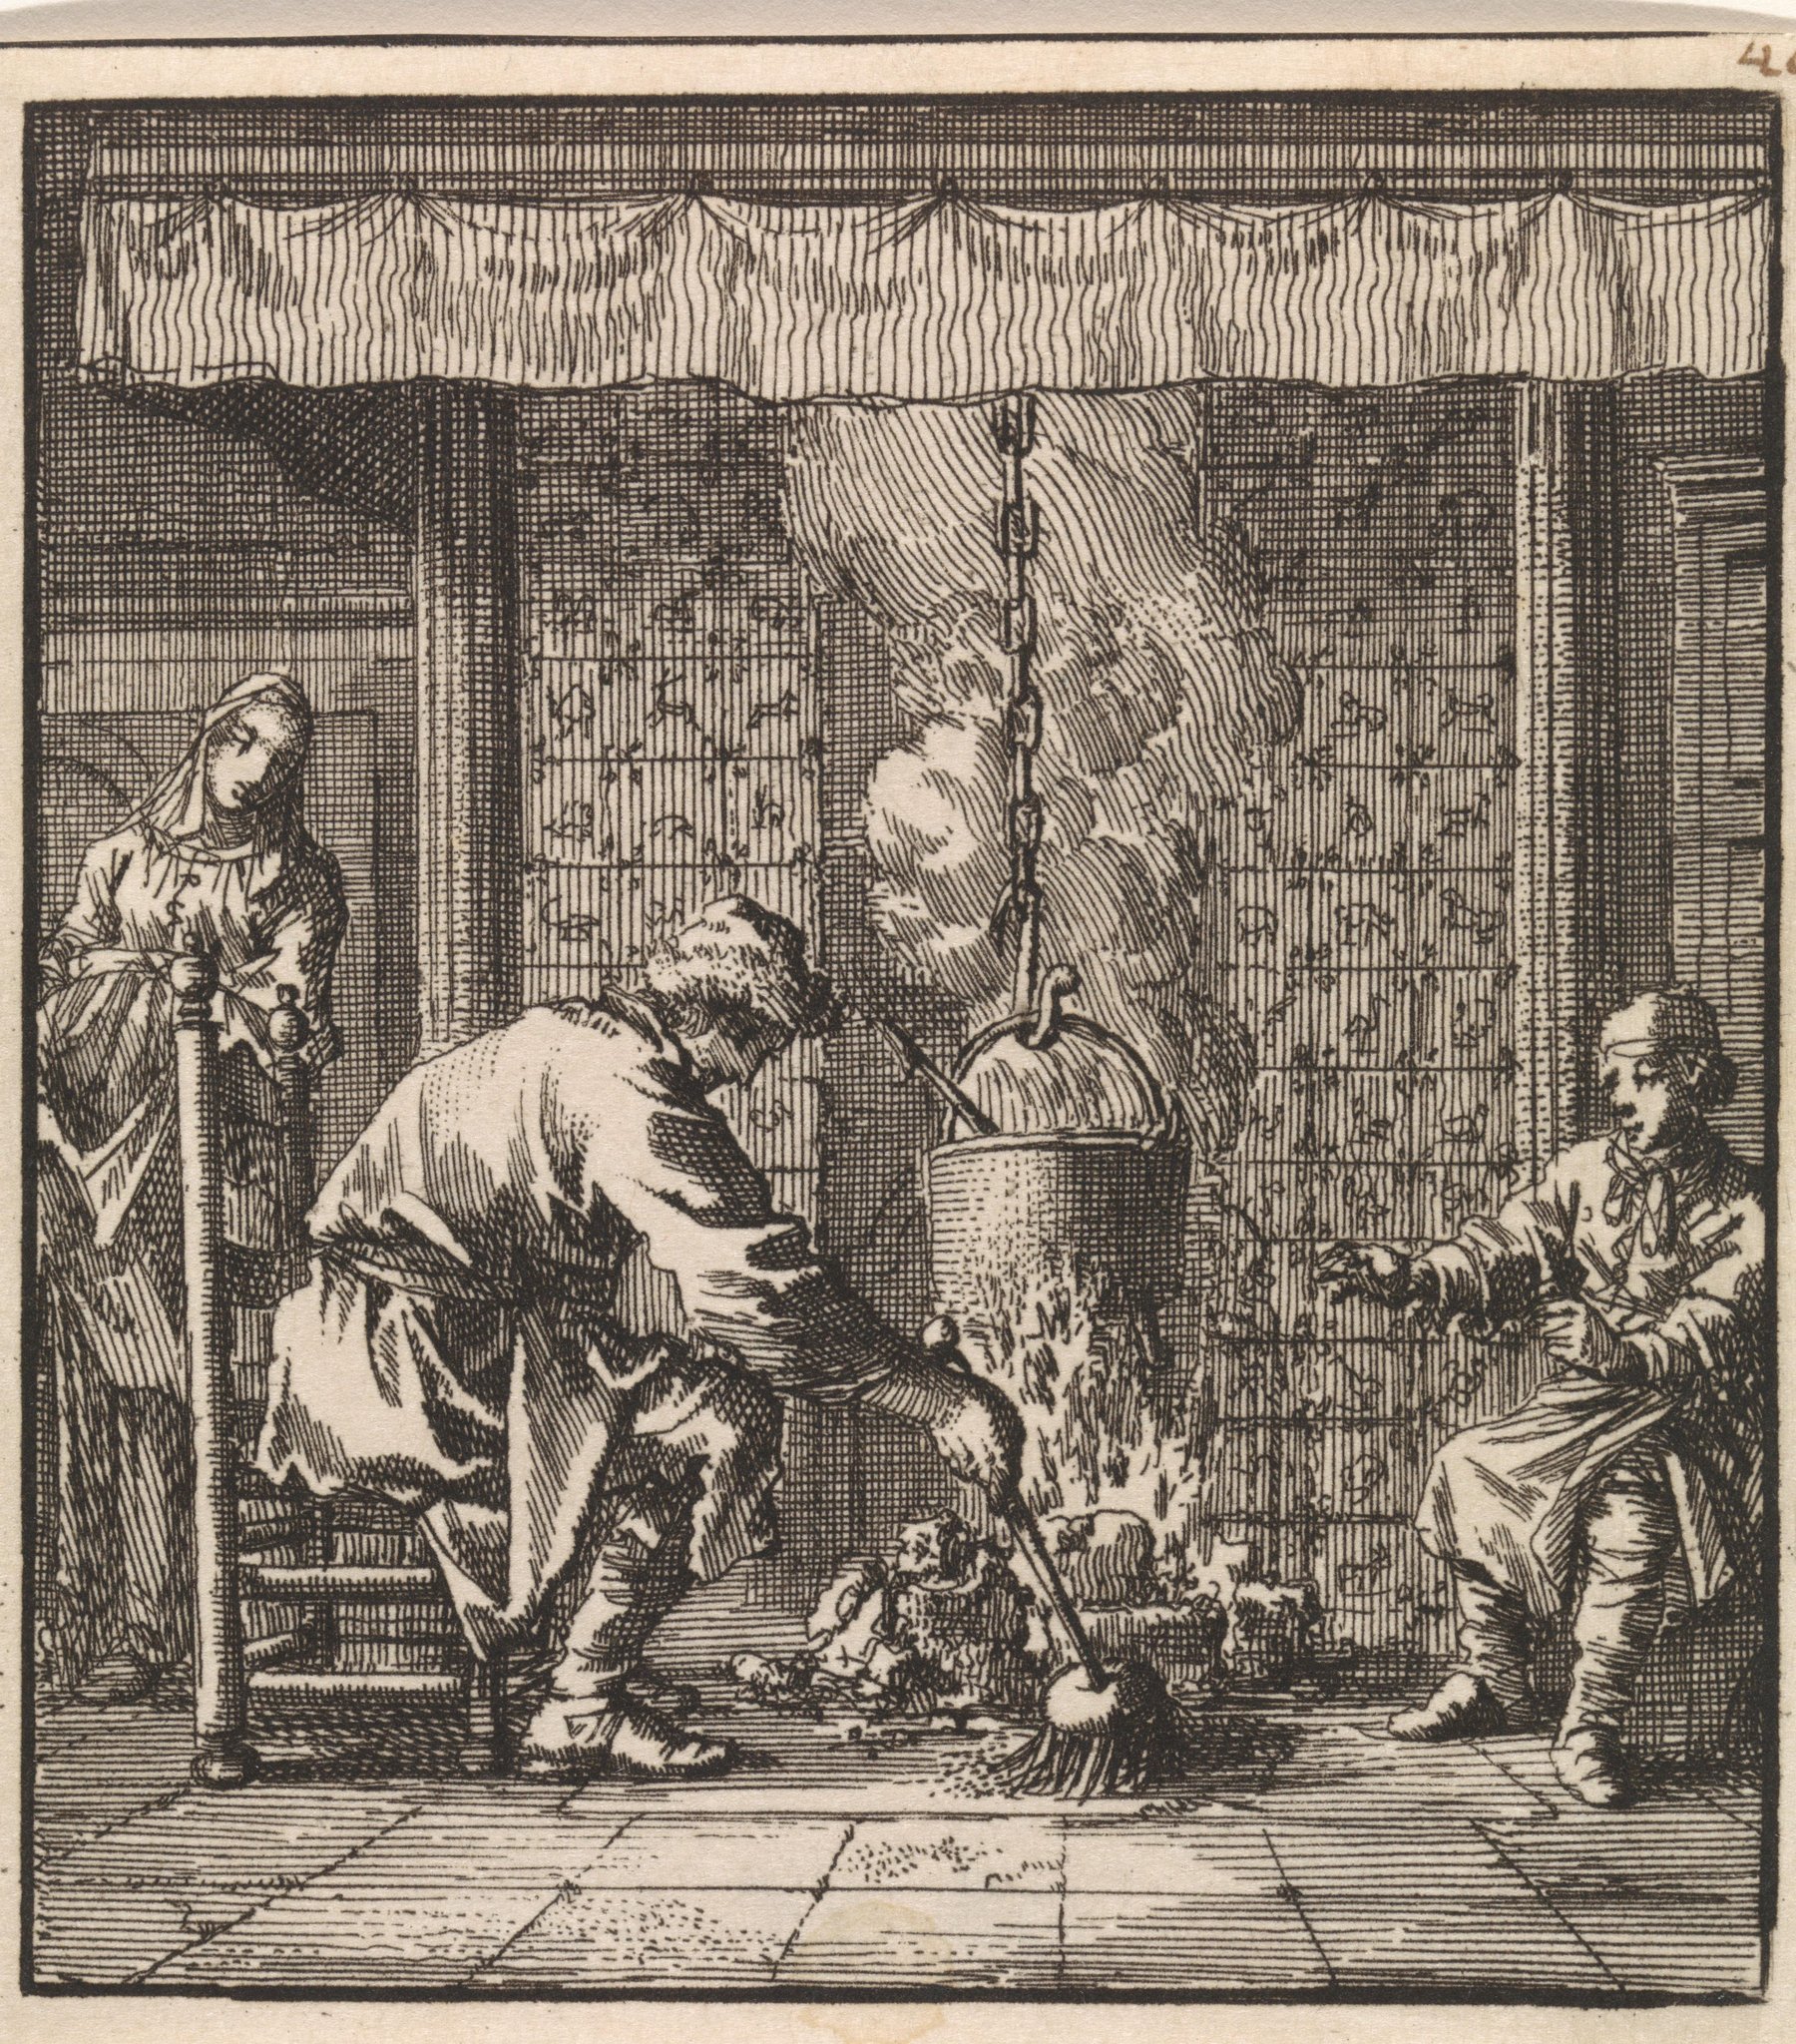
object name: print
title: Man veegt as richting een brandende haard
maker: jan luyken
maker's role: draughtsman, print maker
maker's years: 1649-1712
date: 1711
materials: paper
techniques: etching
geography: amsterdam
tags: chimney, ash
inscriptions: collector's mark: Lugt 2228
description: Proefdruk van illustratie voor: Luyken, Jan. Het leerzaam huisraad, vertoond in vyftig konstige figuuren, met godlyke spreuken en stichtelyke verzen: Pieter Arentsz. II (wed.) en Cornelis van der Sys, 1711, p. 142.